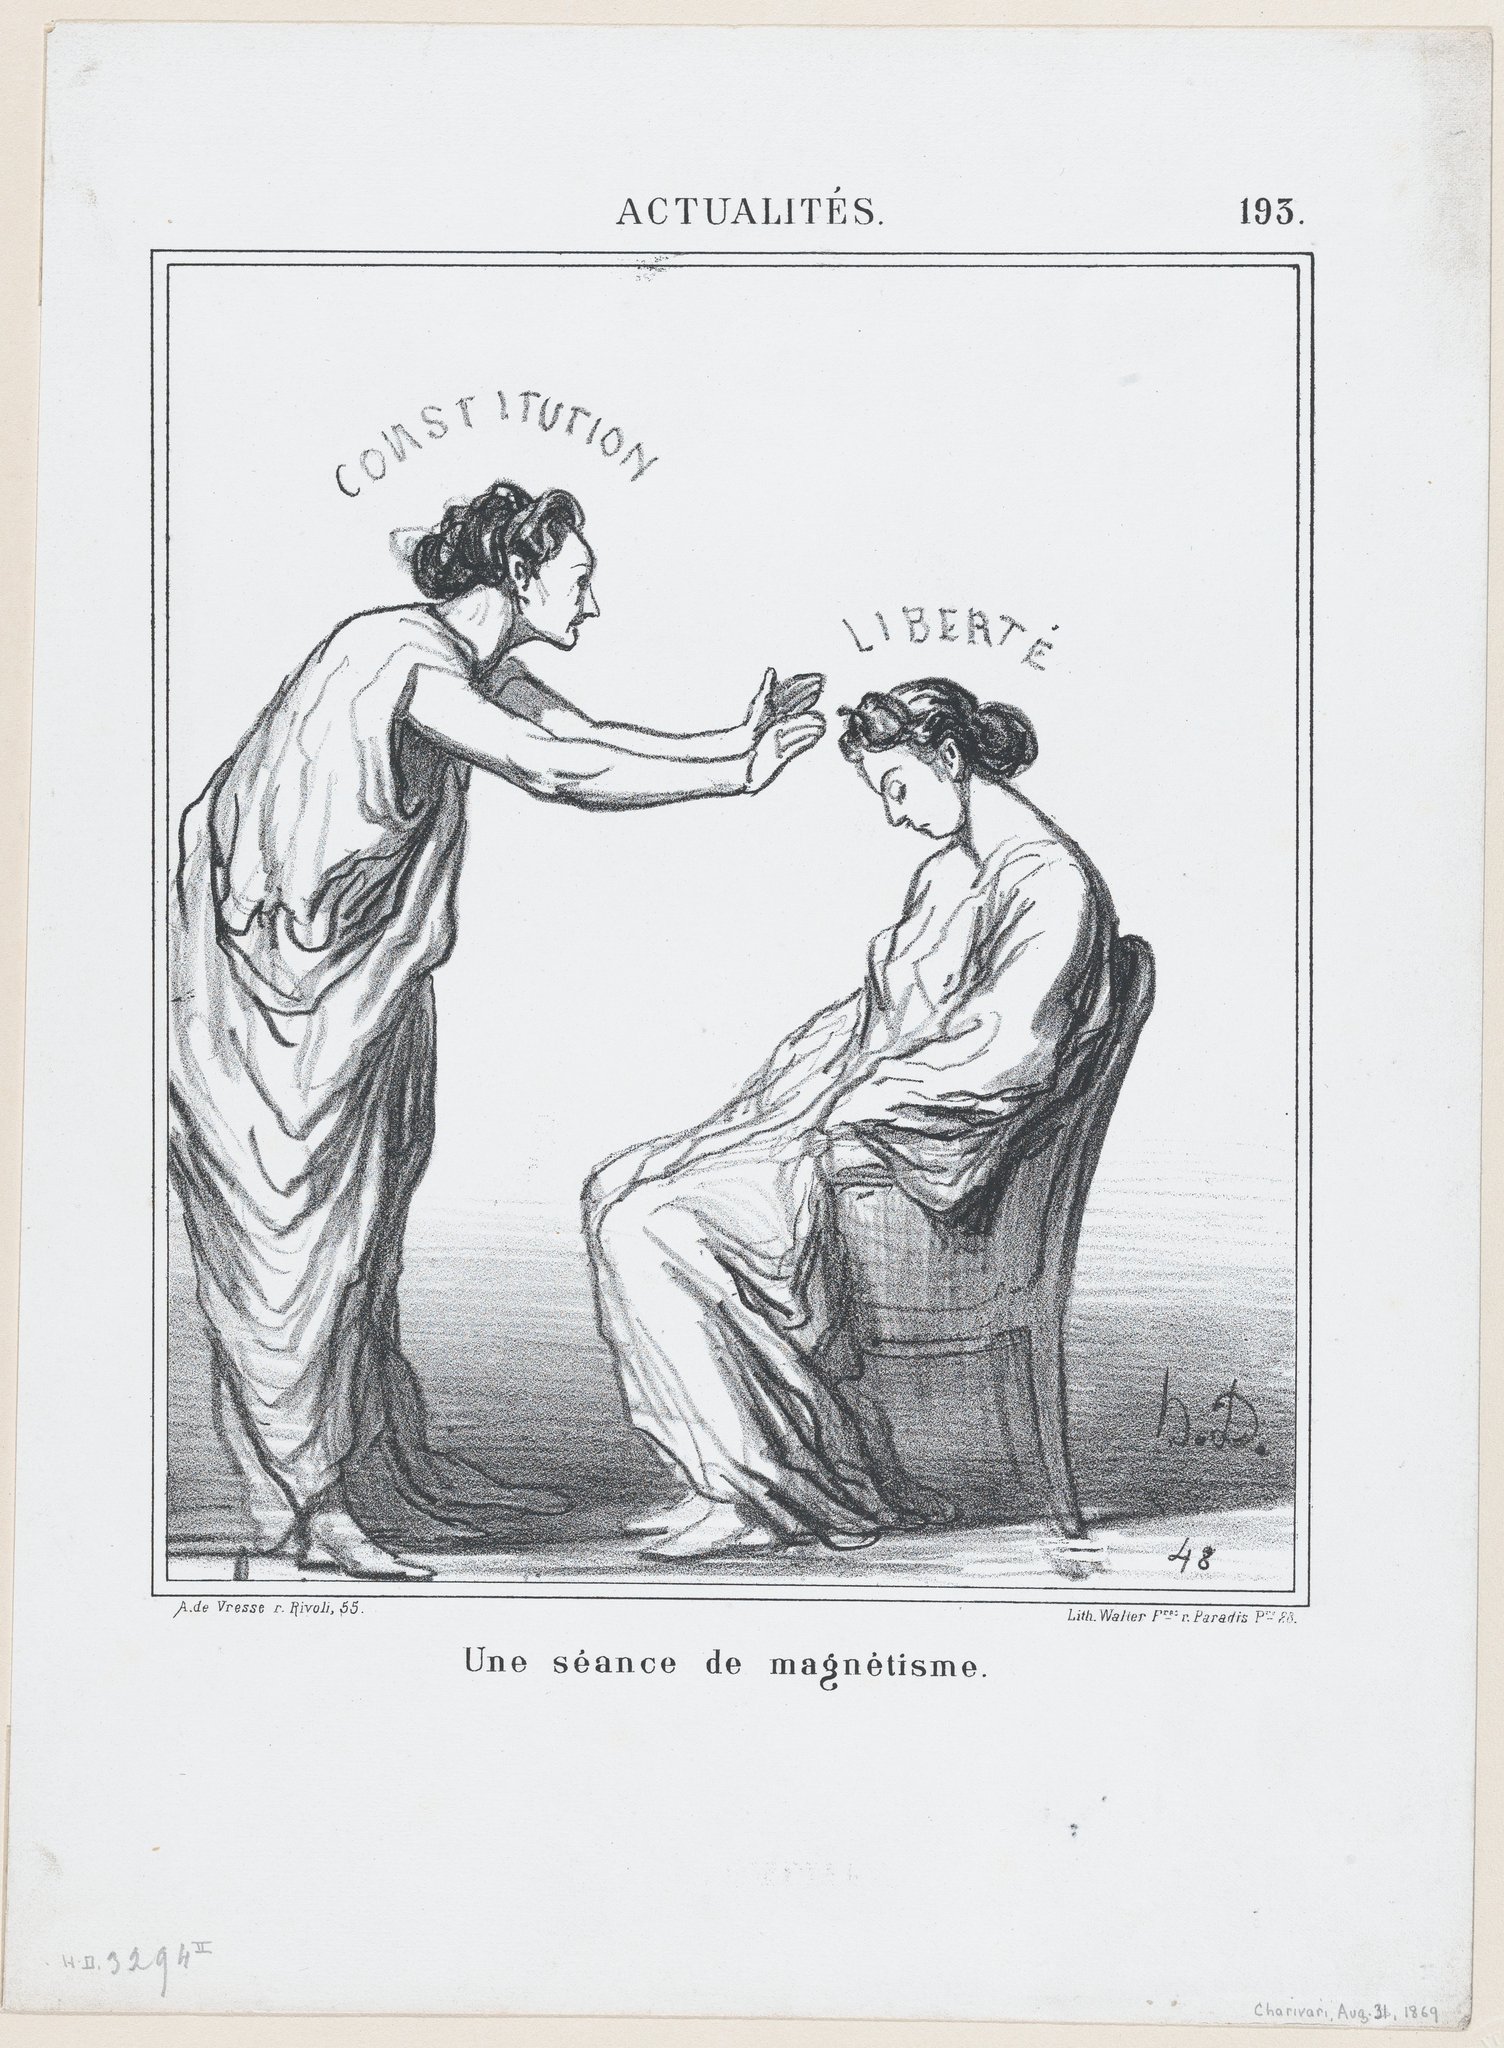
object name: print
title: A session of hypnotism, from 'News of the day,' published in "Le Charivari"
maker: honoré daumier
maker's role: artist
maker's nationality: french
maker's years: 1808-1879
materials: paper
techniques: lithograph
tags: satire,women